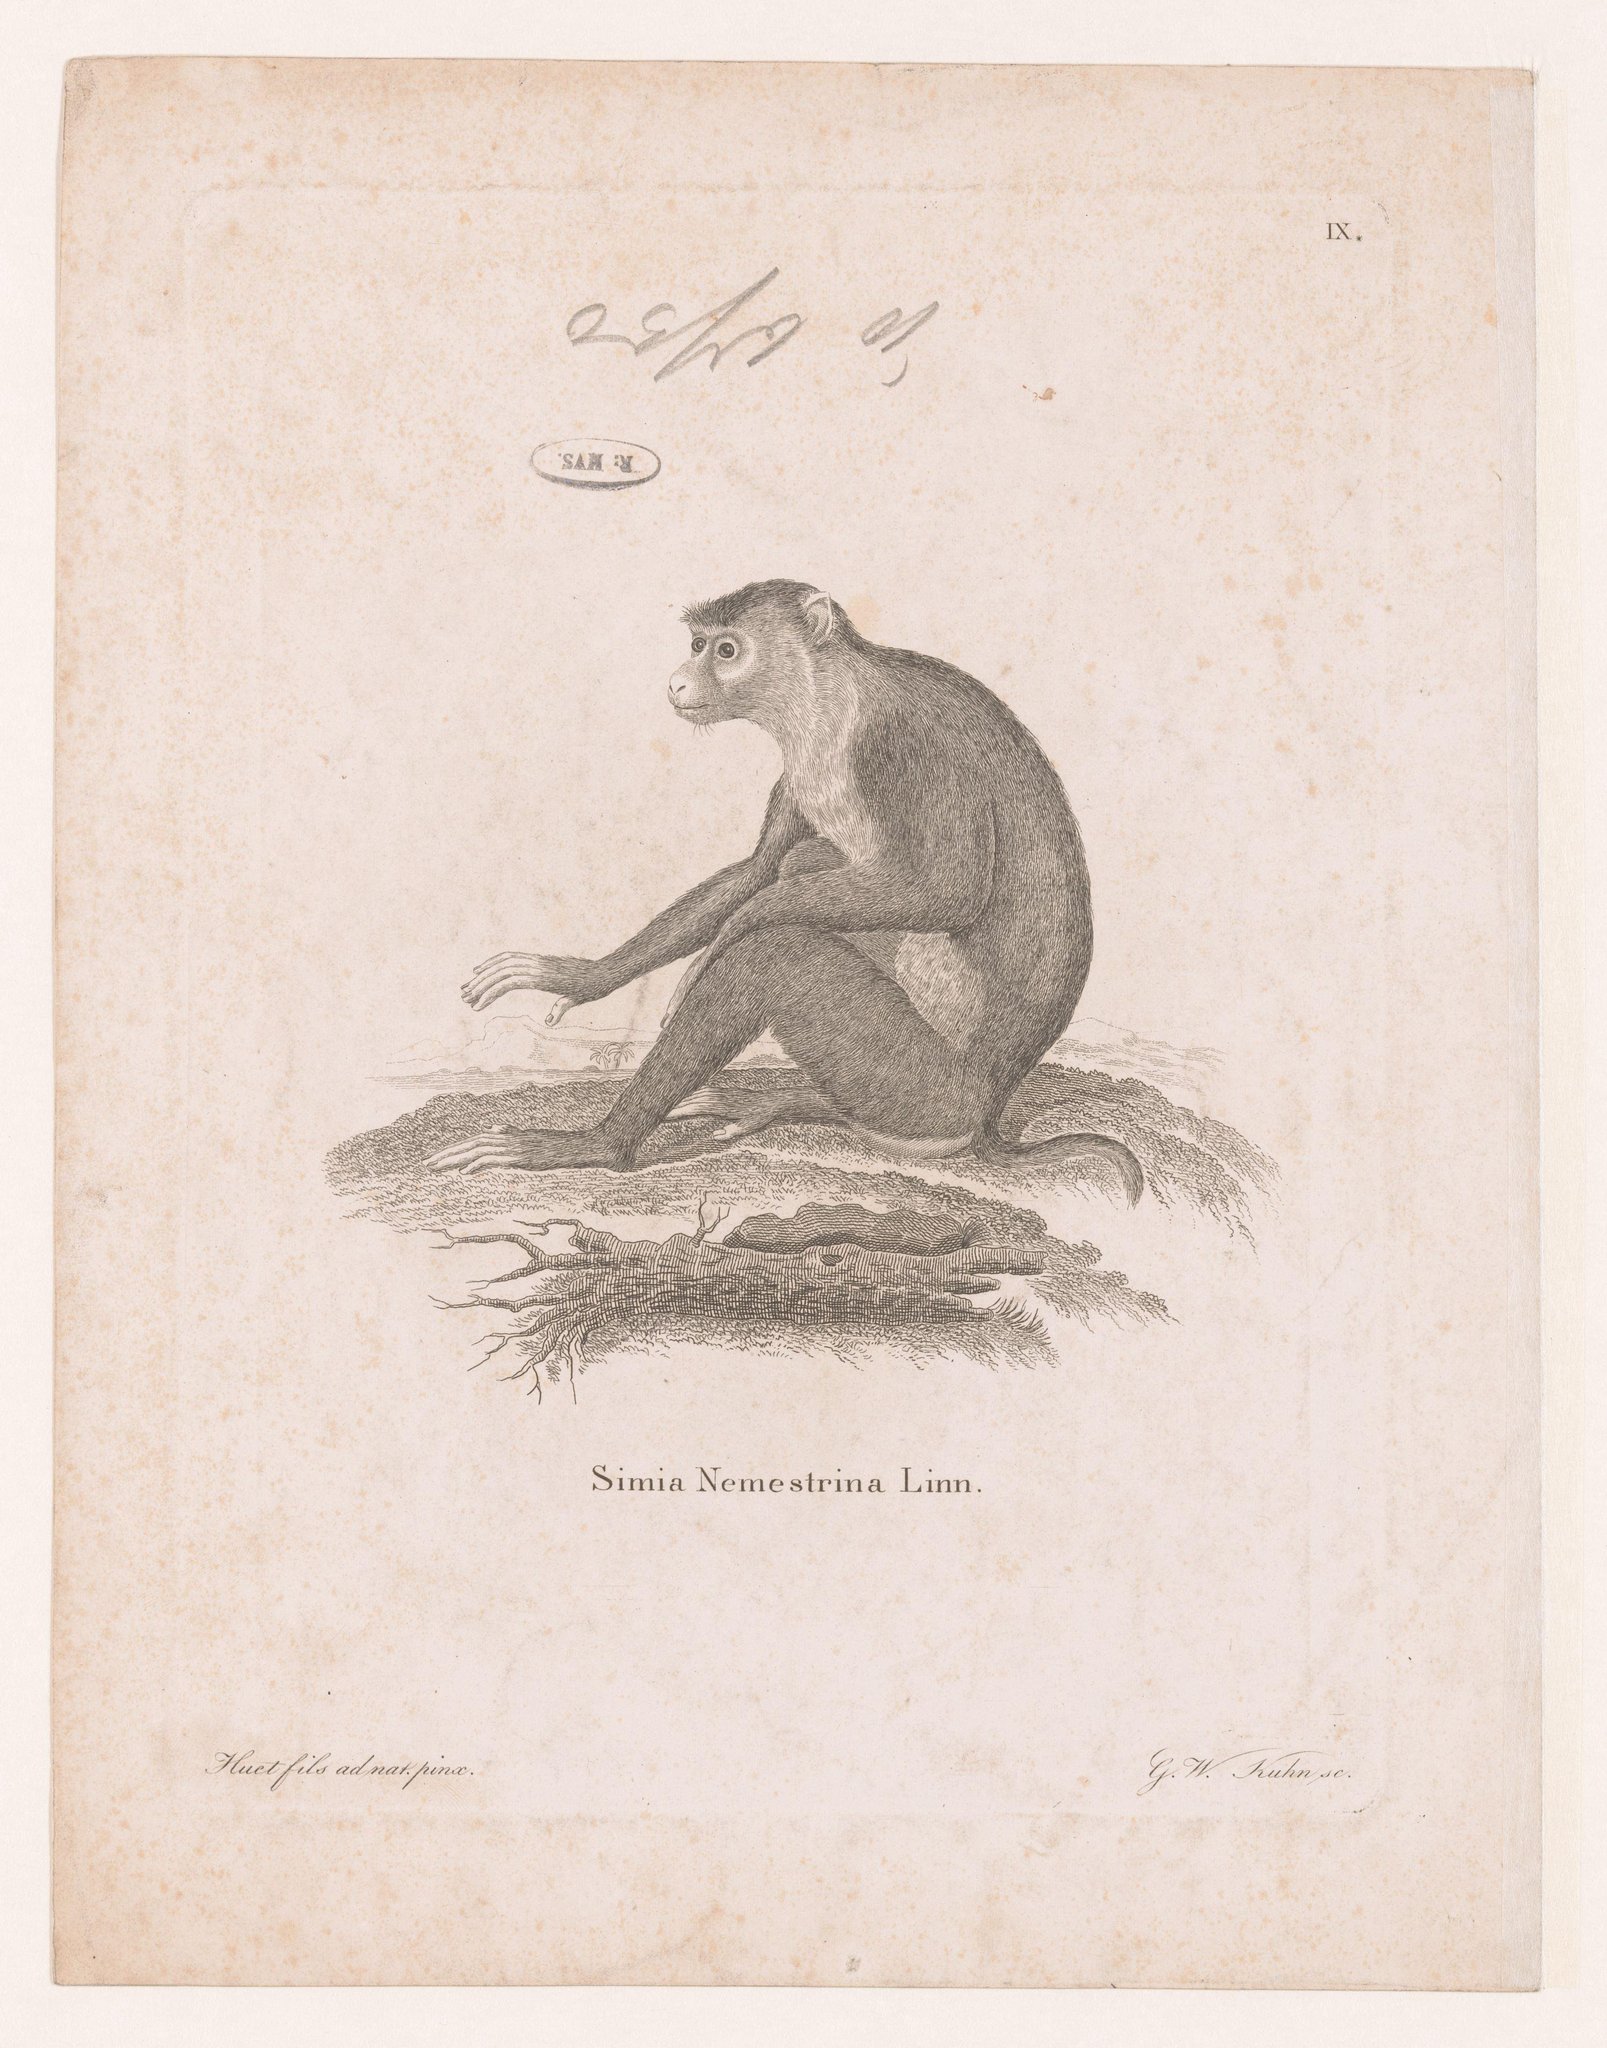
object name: print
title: Simia Nemestrina Linn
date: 1766-1799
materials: paper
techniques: engraving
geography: leipzig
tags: monkeys, apes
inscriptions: collector's mark: Lugt 2228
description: Volgens de titel betreft het de door Carolus Linnaeus beschreven lampongaap (simia nemestrina). Genummerd rechtsboven: IX.